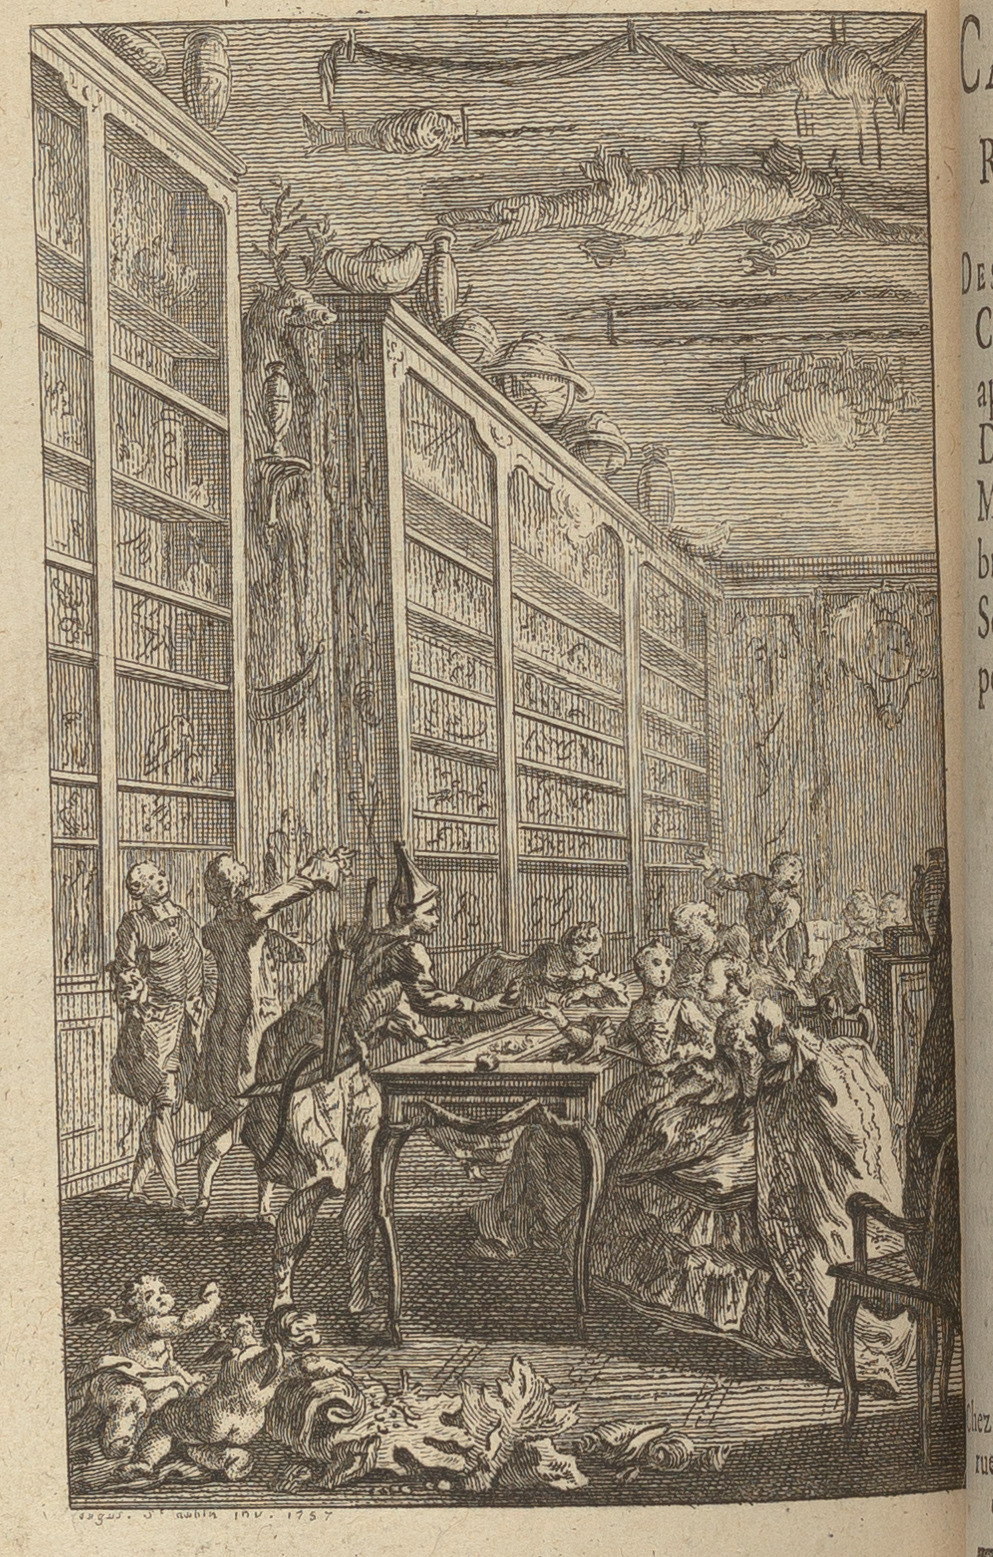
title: Catalogue raisonné des tableaux, estampes, coquilles, & autres curiosités : après le décès de feu Monsieur Dezalier d'Argenville, maître des comptes, & membre des Sociétés royale de Londres & de Monpellier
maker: augustin de saint-aubin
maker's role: illustrator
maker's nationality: french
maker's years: 1736-1807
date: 1766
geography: france